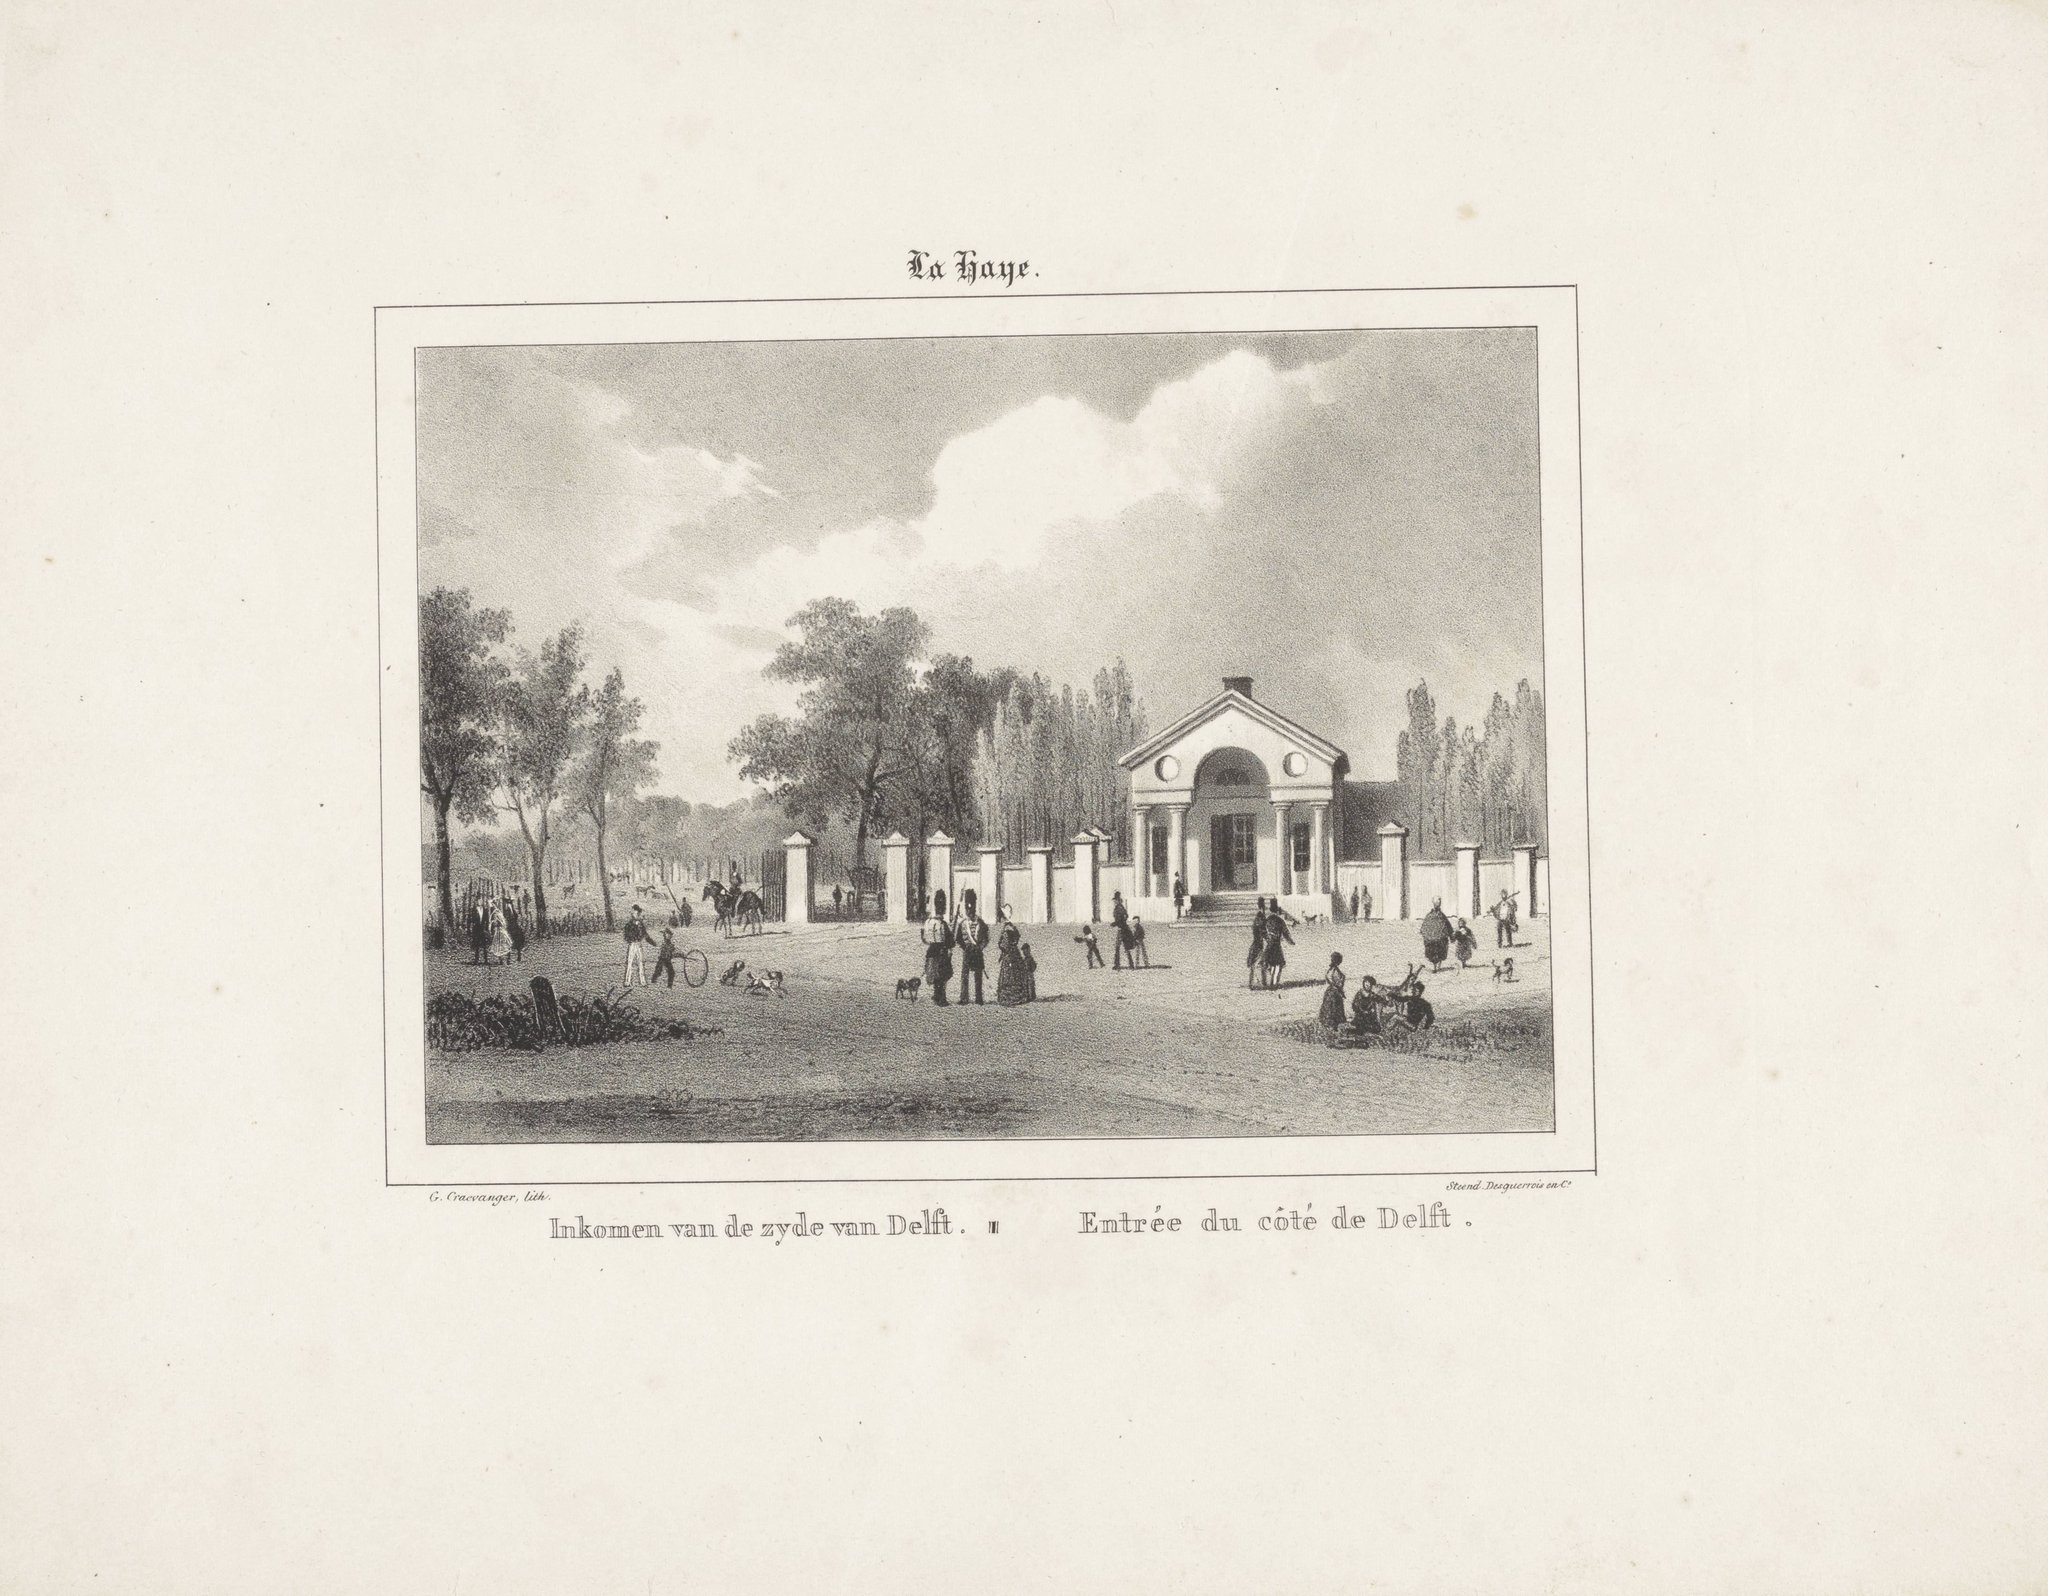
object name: print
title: Tolhuis aan het Rijswijkseplein in Den Haag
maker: gijsbertus craeyvanger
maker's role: draughtsman, print maker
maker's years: 1810-1895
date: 1820-1895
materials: paper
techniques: lithograph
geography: amsterdam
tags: toll gate, city-view, and landscape with man-made constructions (+ city(-scape) with figures, staffage), the hague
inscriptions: collector's mark: Lugt 2228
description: Aan weerszijden van het tolhuis staat een hek. Links is een doorgang naar een weide met koeien. Voor het tolhuis staan en lopen figuren.